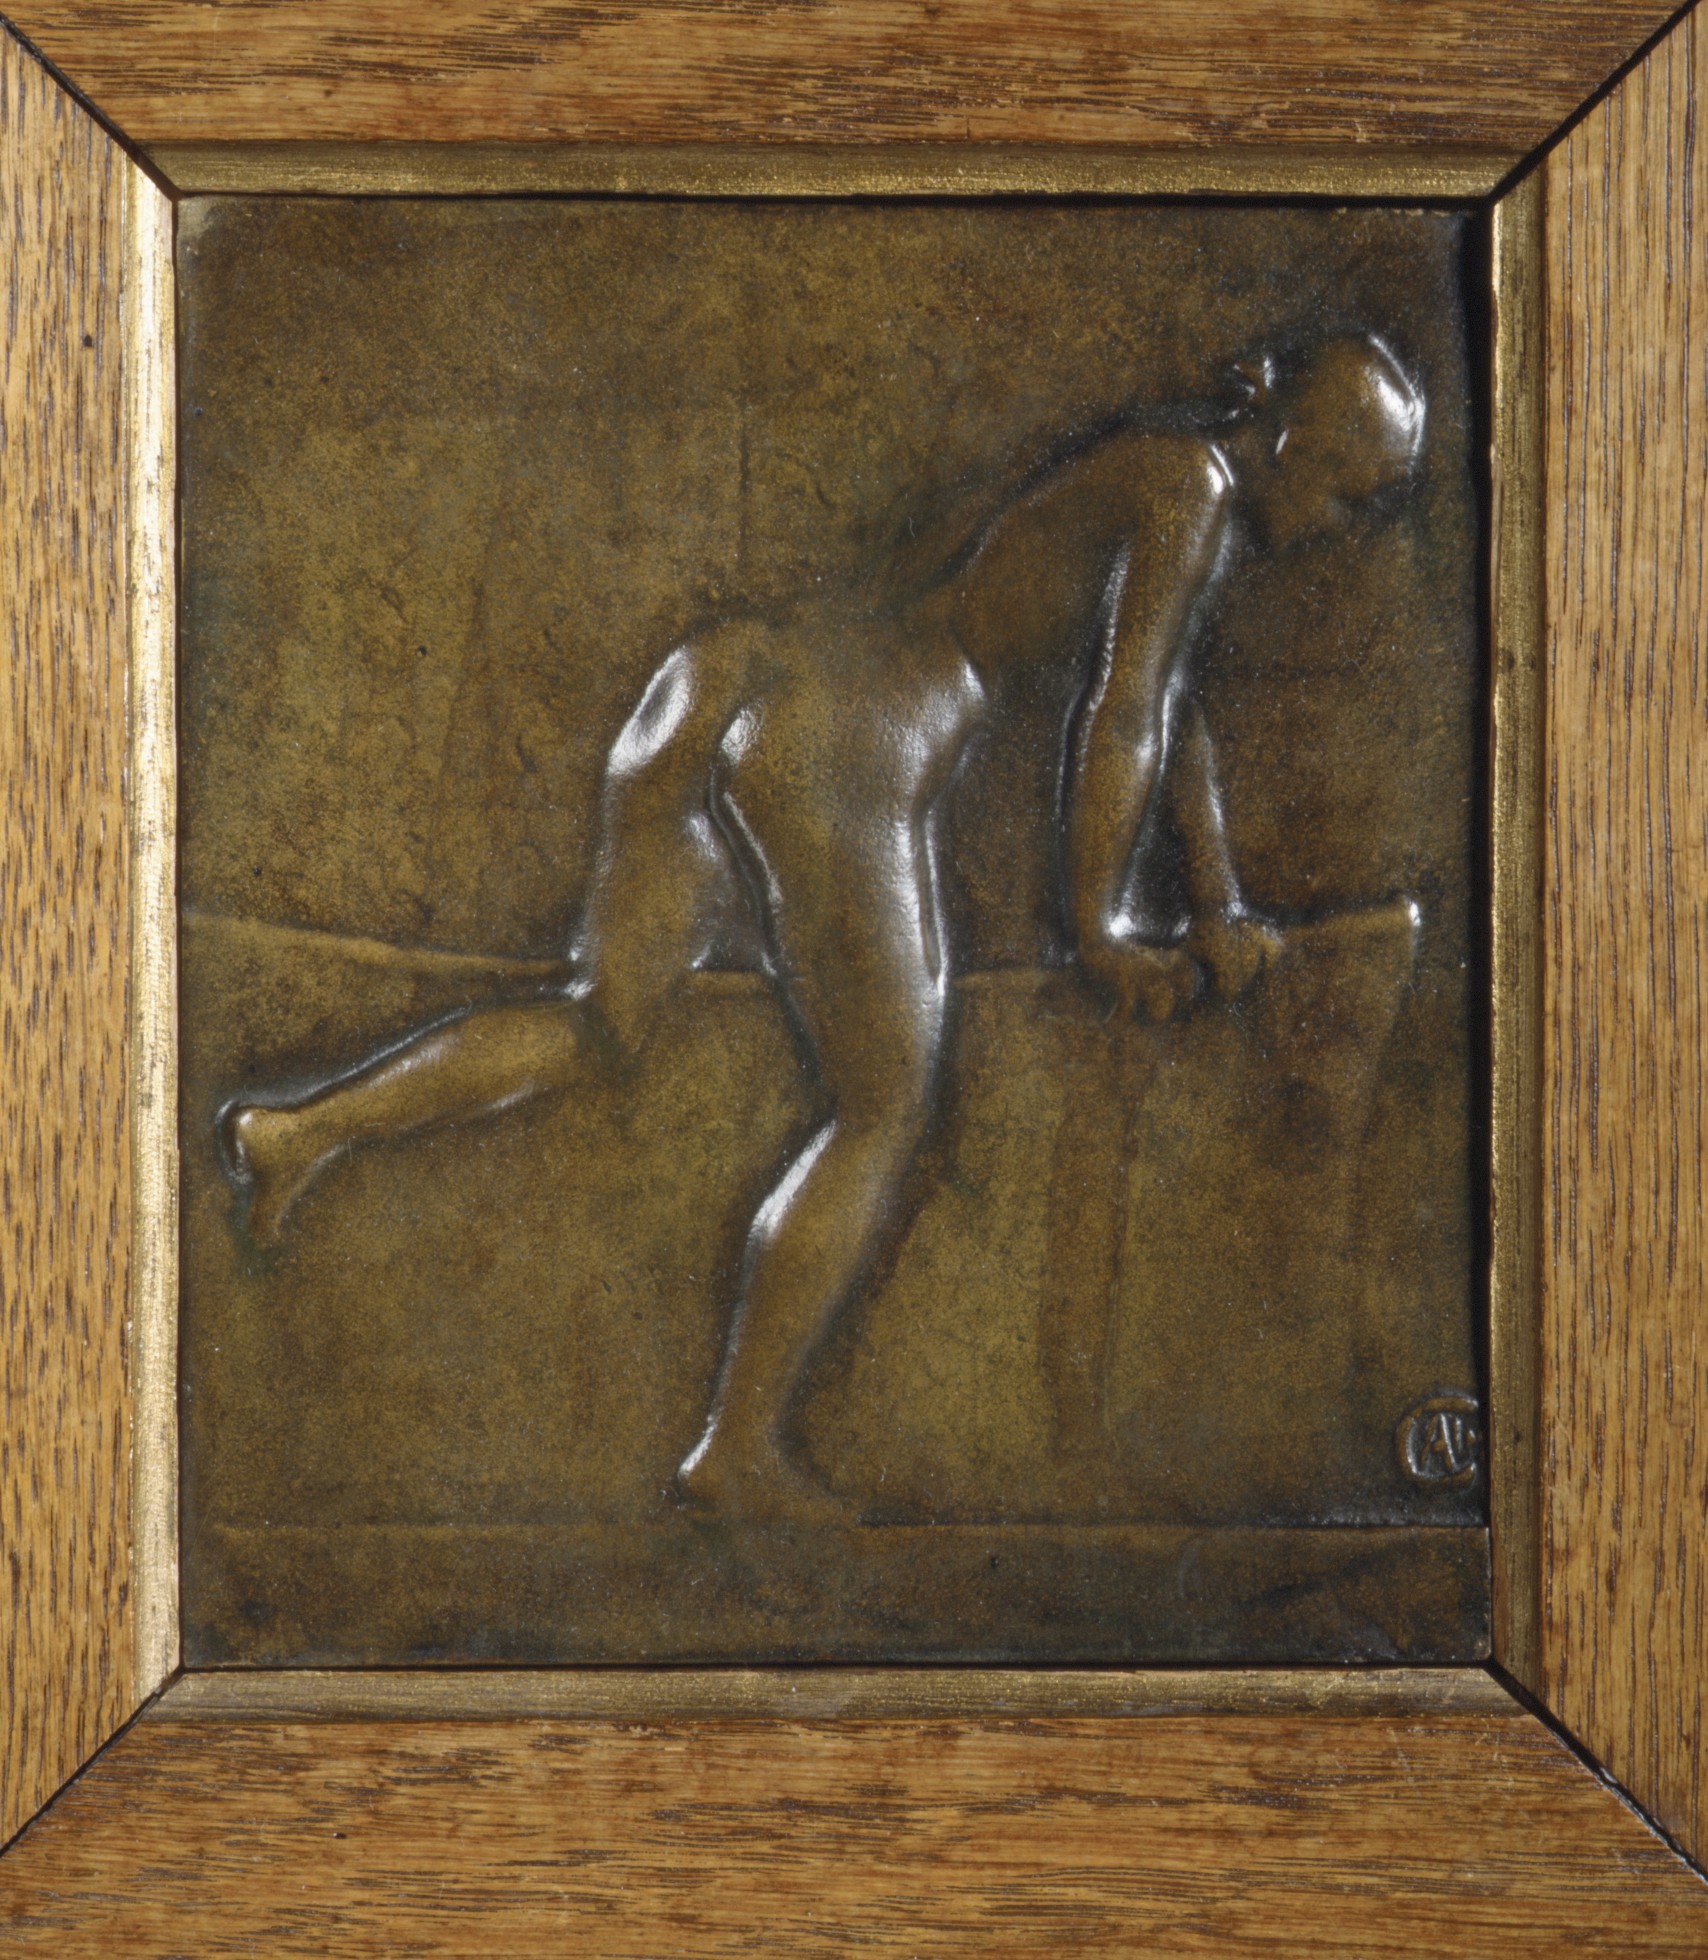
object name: plaquette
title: Nude at the Bathtub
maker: alexandre-louis-marie charpentier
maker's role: artist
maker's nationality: french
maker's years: 1856-1909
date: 1890-1900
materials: bronze, wood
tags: female nudes